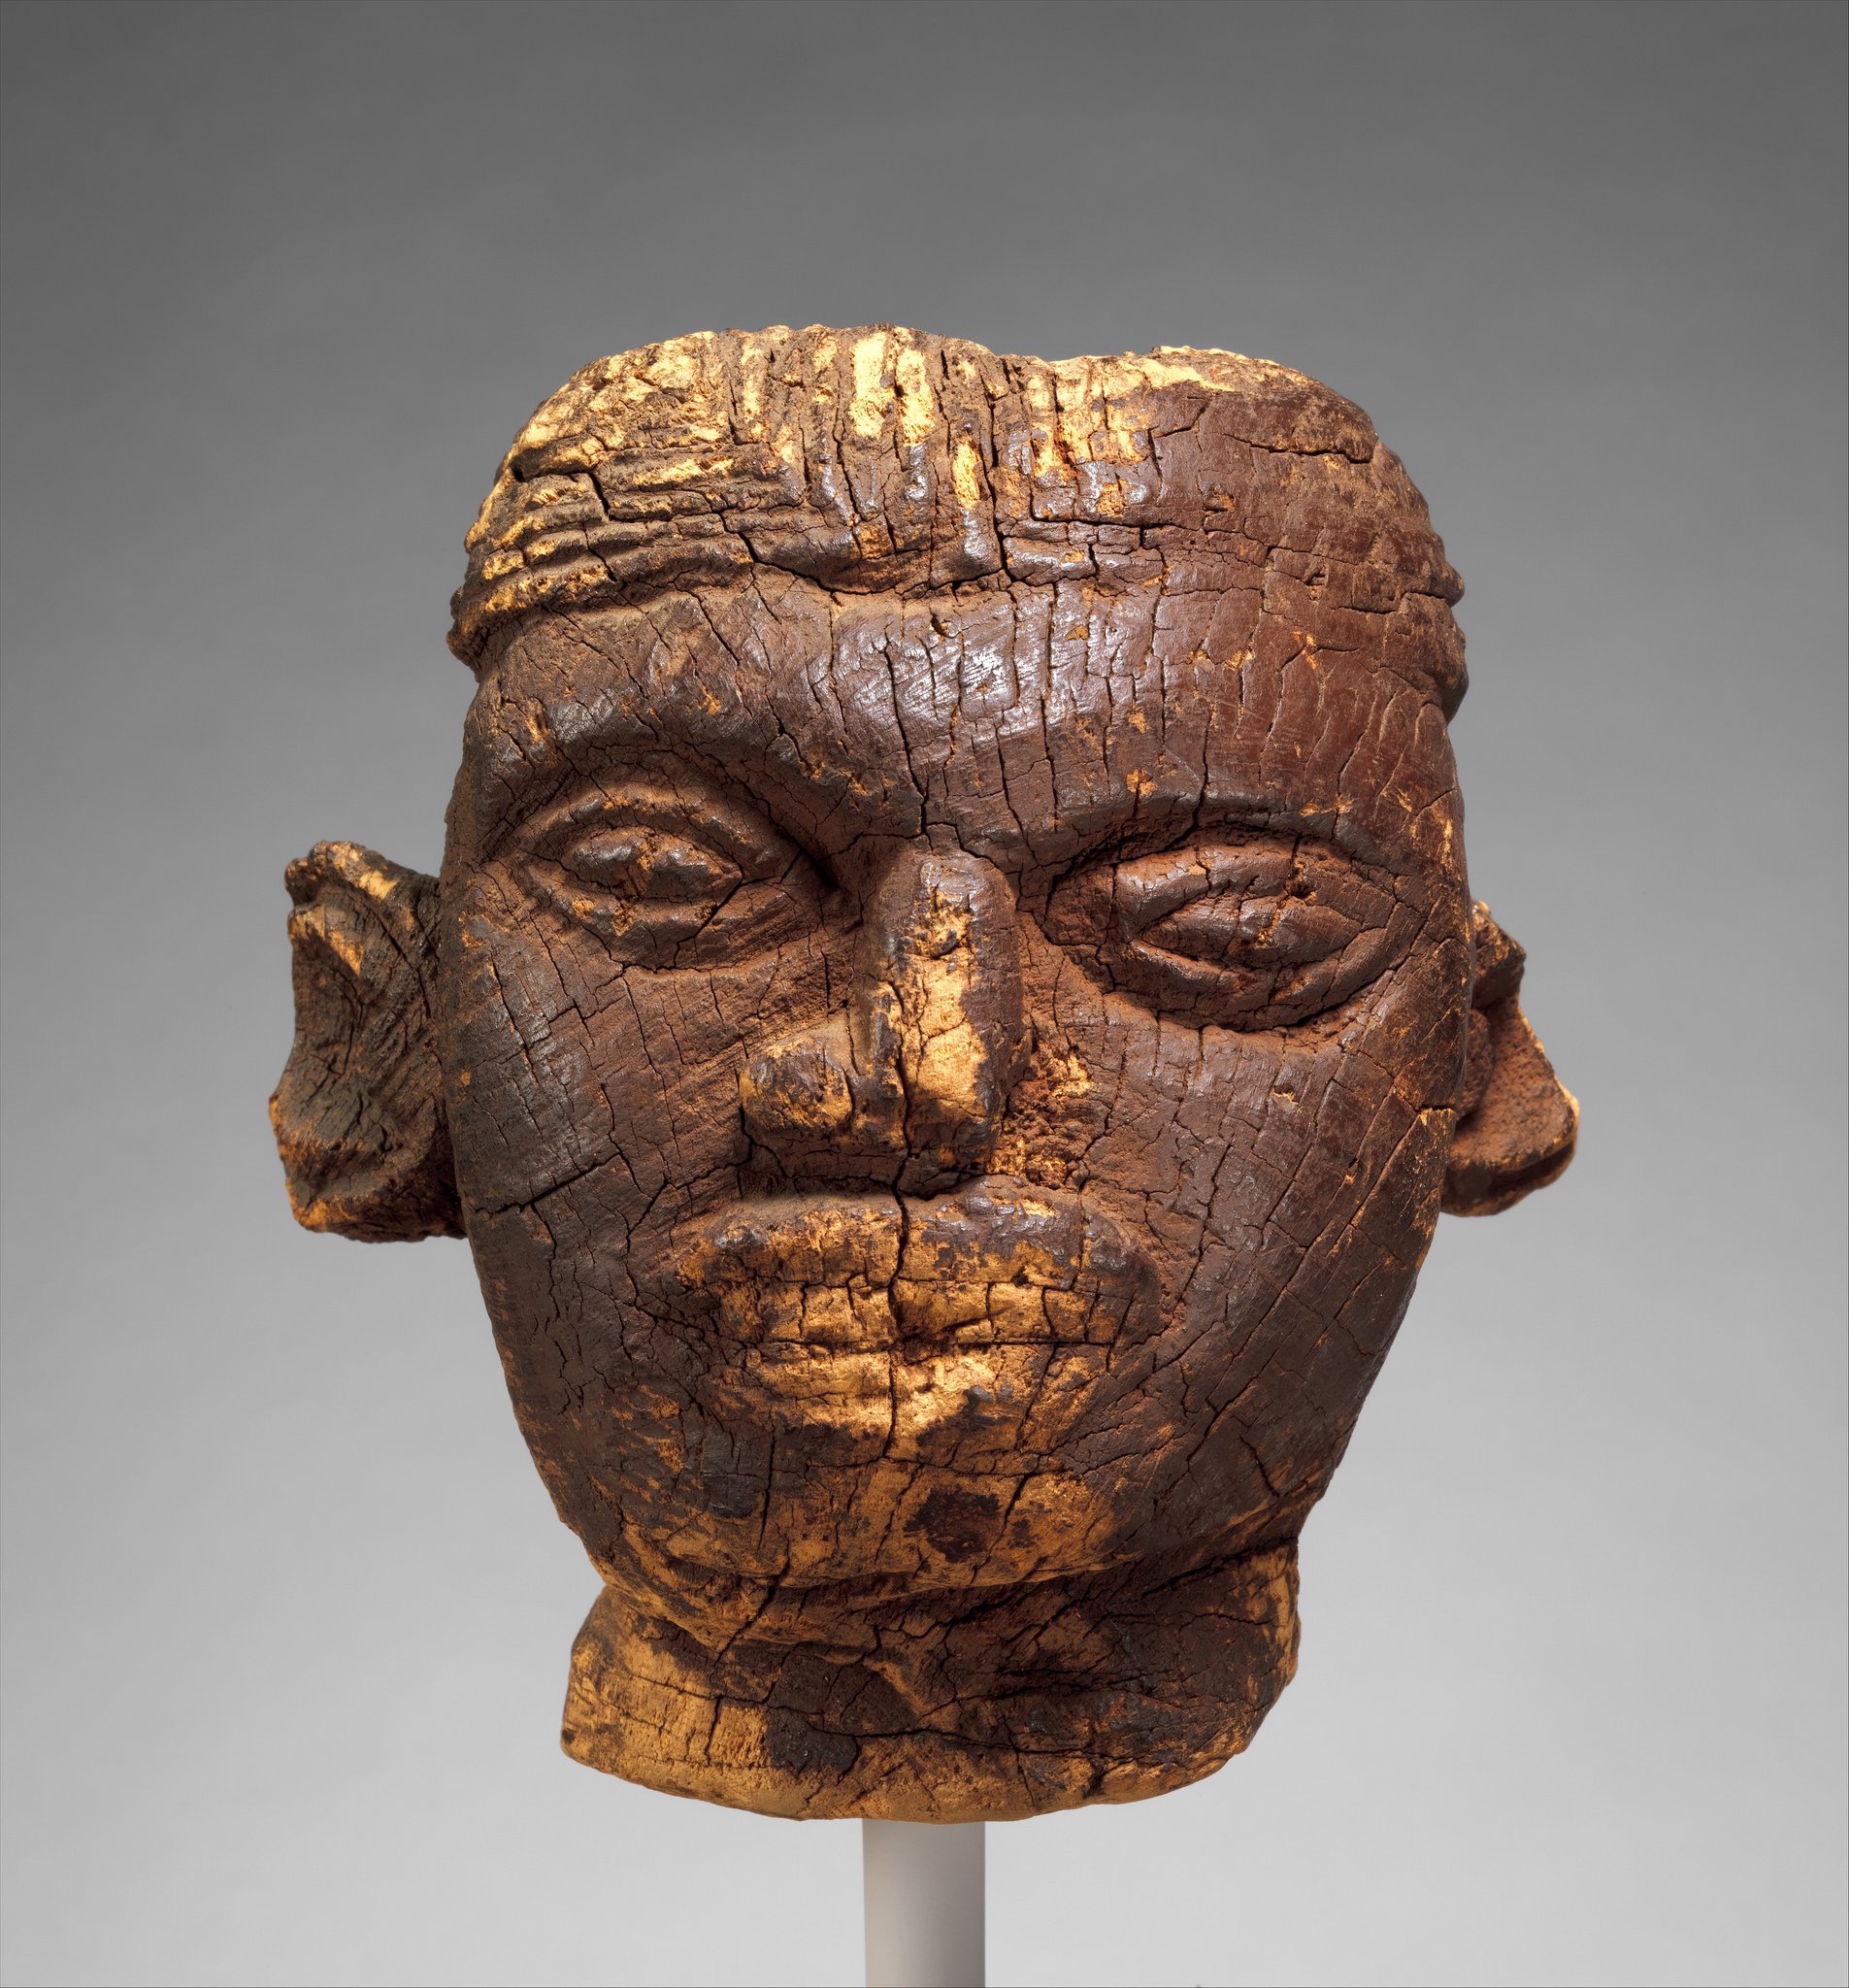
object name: drum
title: Head from a slit drum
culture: bamileke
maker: grassfields artist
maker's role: artist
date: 1867-1900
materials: wood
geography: cameroon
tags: heads